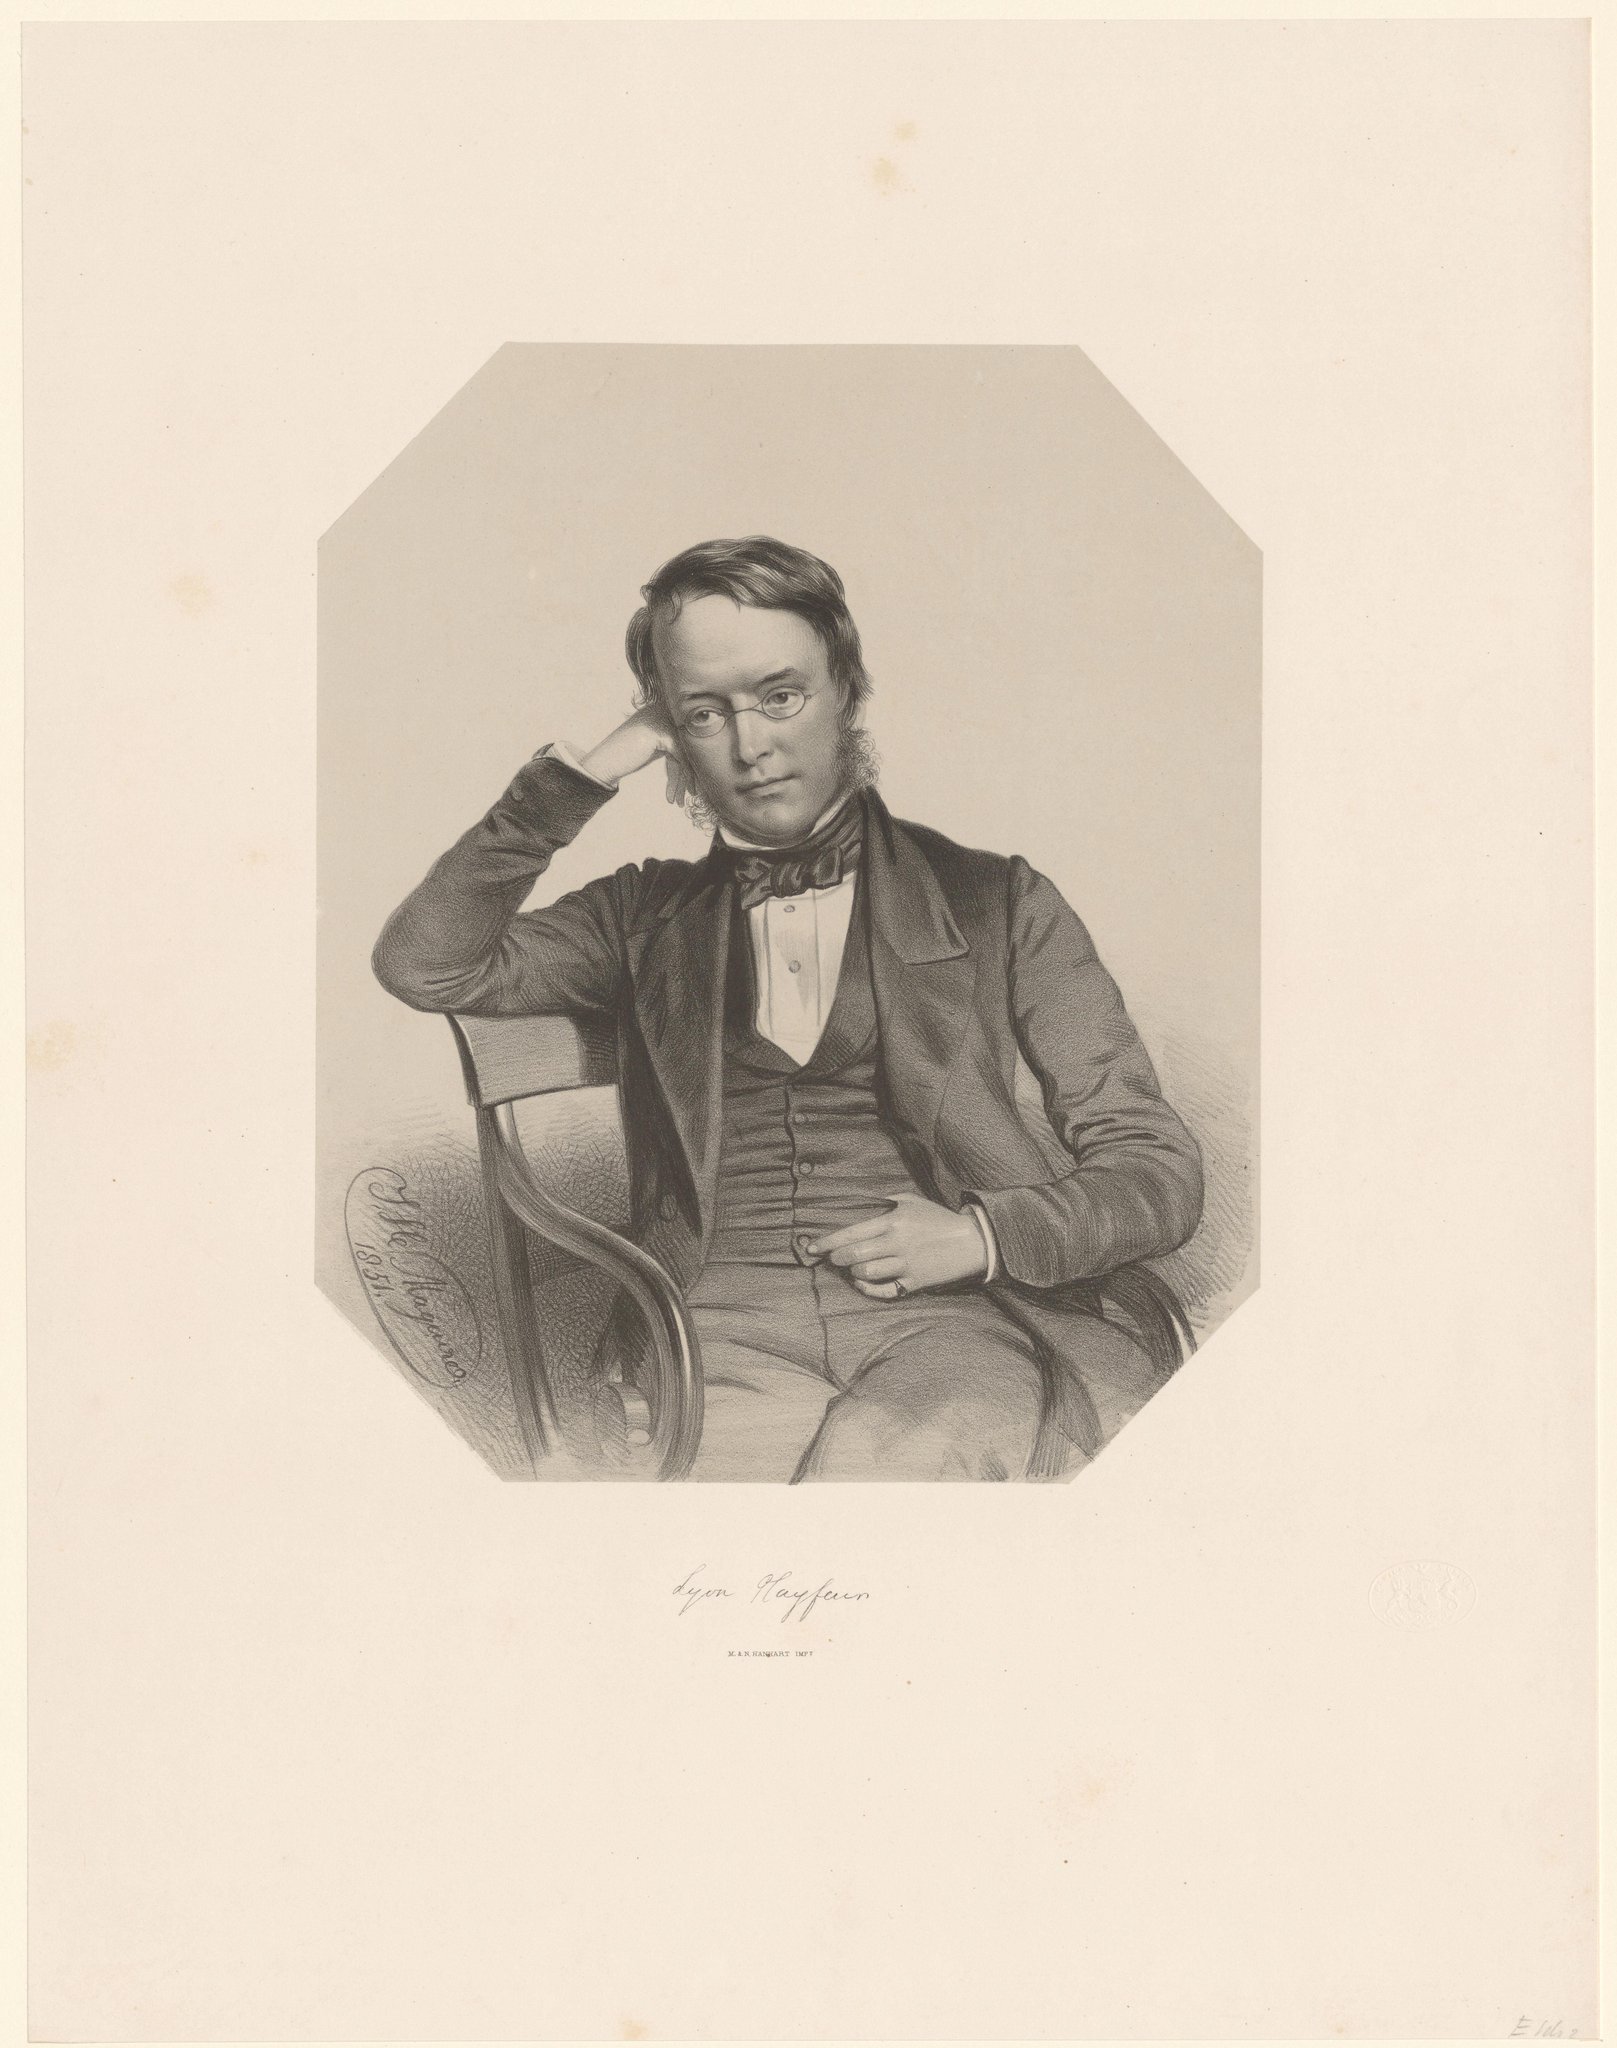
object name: print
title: Ipswich Museum Portraits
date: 1852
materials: paper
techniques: lithograph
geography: london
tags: adult man, historical persons, chair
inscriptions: check stamp: ‘Ipswich Museum’, collector's mark: Lugt 2228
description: Prent behoort tot de serie 'Ipswich Museum Portraits', ook bekend onder de titel 'Portraits of Honorary Members of the Ipswich Museum'. Deze serie is in 1852 door George Ransome uitgegeven en gedrukt door M&N Hanhart tussen 1848 en 1852. De serie bestaat uit ca. 60 portretten.